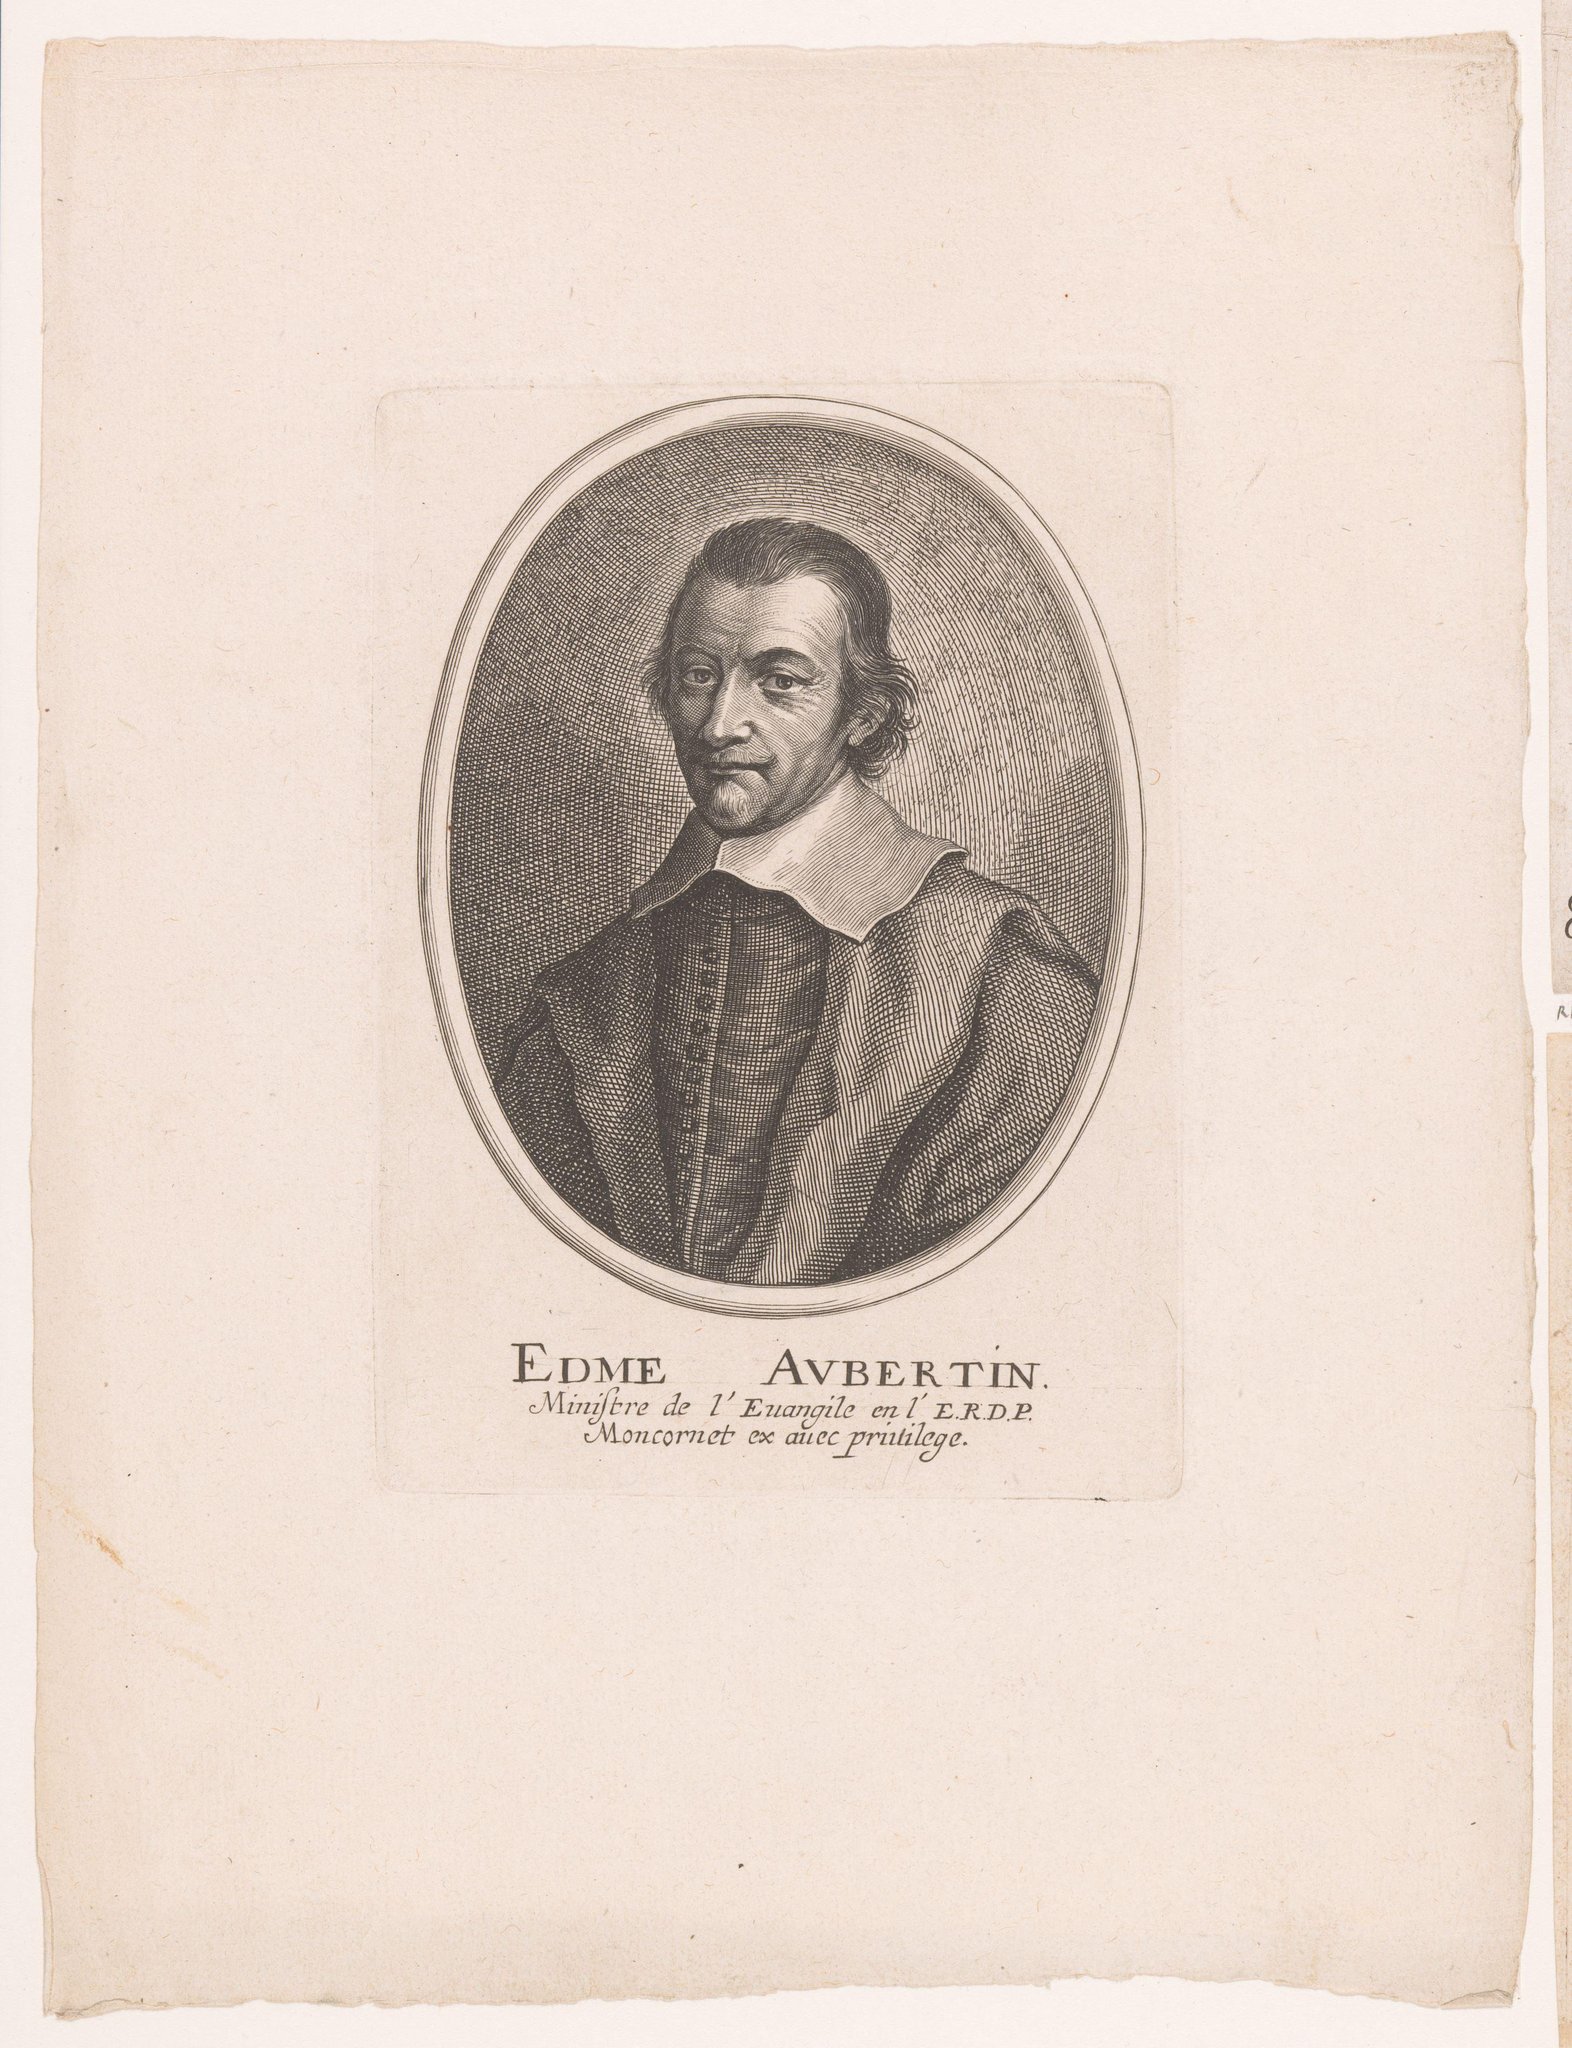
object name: print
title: Portret van Edme Aubertin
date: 1610-1668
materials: paper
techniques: engraving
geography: paris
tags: paris, historical persons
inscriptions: collector's mark: Lugt 2228